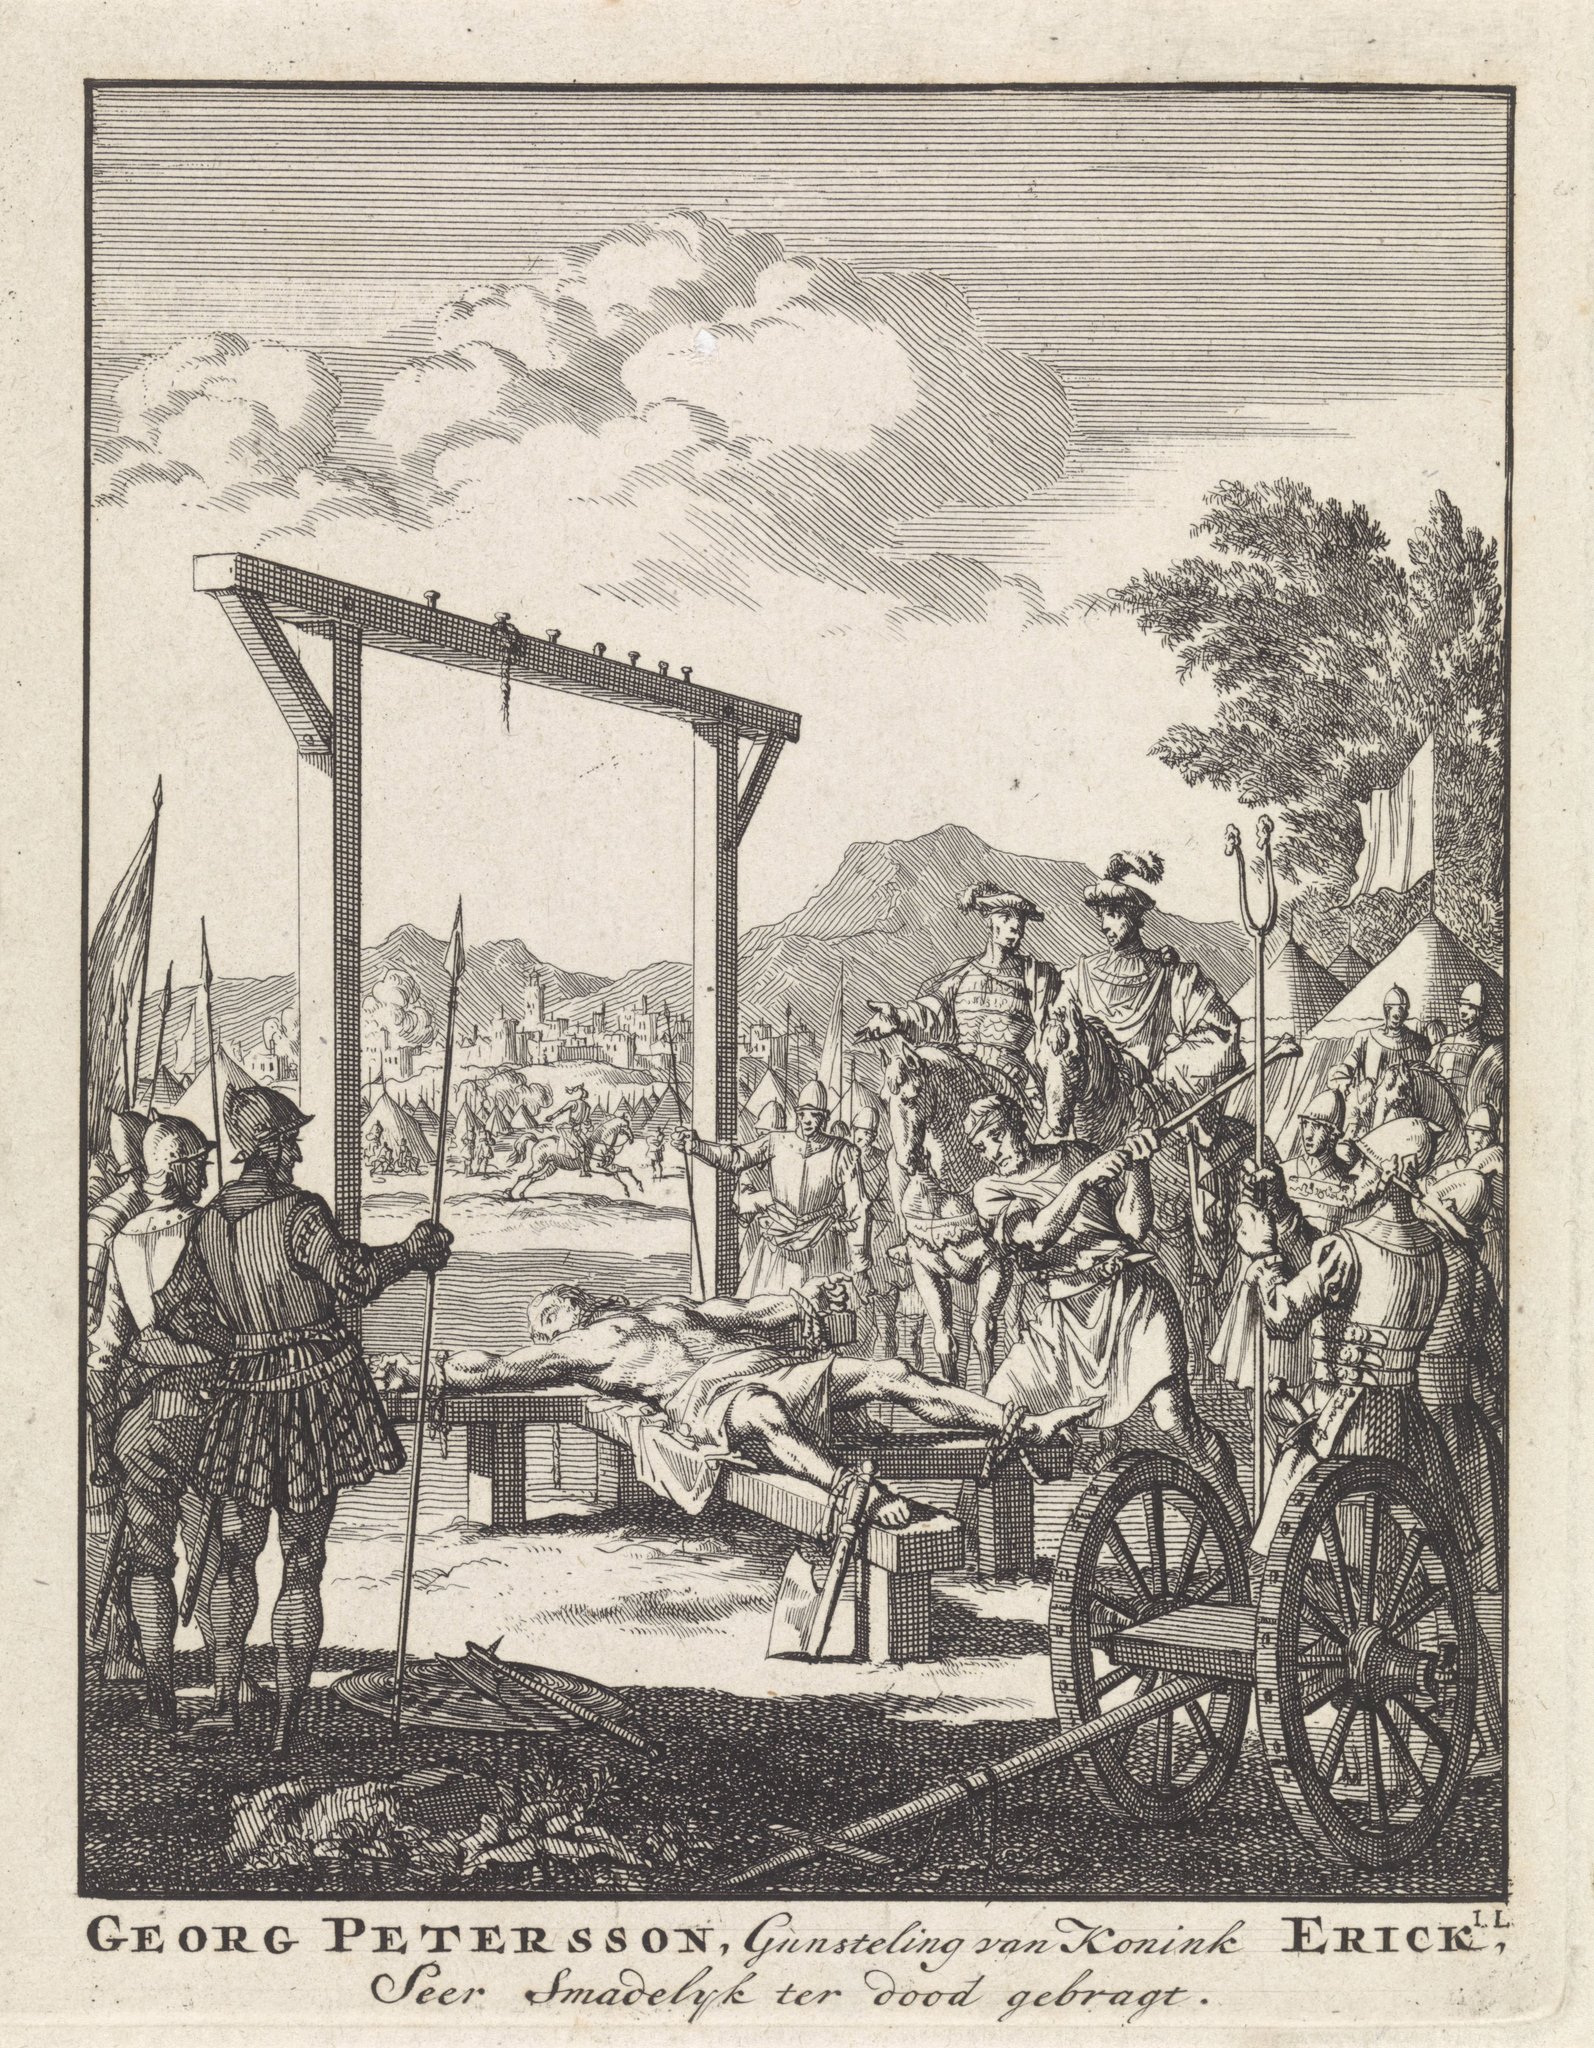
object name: print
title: Georg Petersson, Gunsteling van Konink Erick, Seer Smadelyk ter dood gebragt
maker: jan luyken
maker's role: draughtsman, print maker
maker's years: 1649-1712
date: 1698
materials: paper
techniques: etching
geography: amsterdam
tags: violent death by breaking on the wheel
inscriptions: collector's mark: Lugt 2228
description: Proefdruk van illustratie uit: Bos, Lambert van den. Treur-toonneel der doorluchtige mannen, of Op- en ondergang der grooten, 3 delen. Amsterdam: Jan Claesz ten Hoorn, 1698, dl. I.